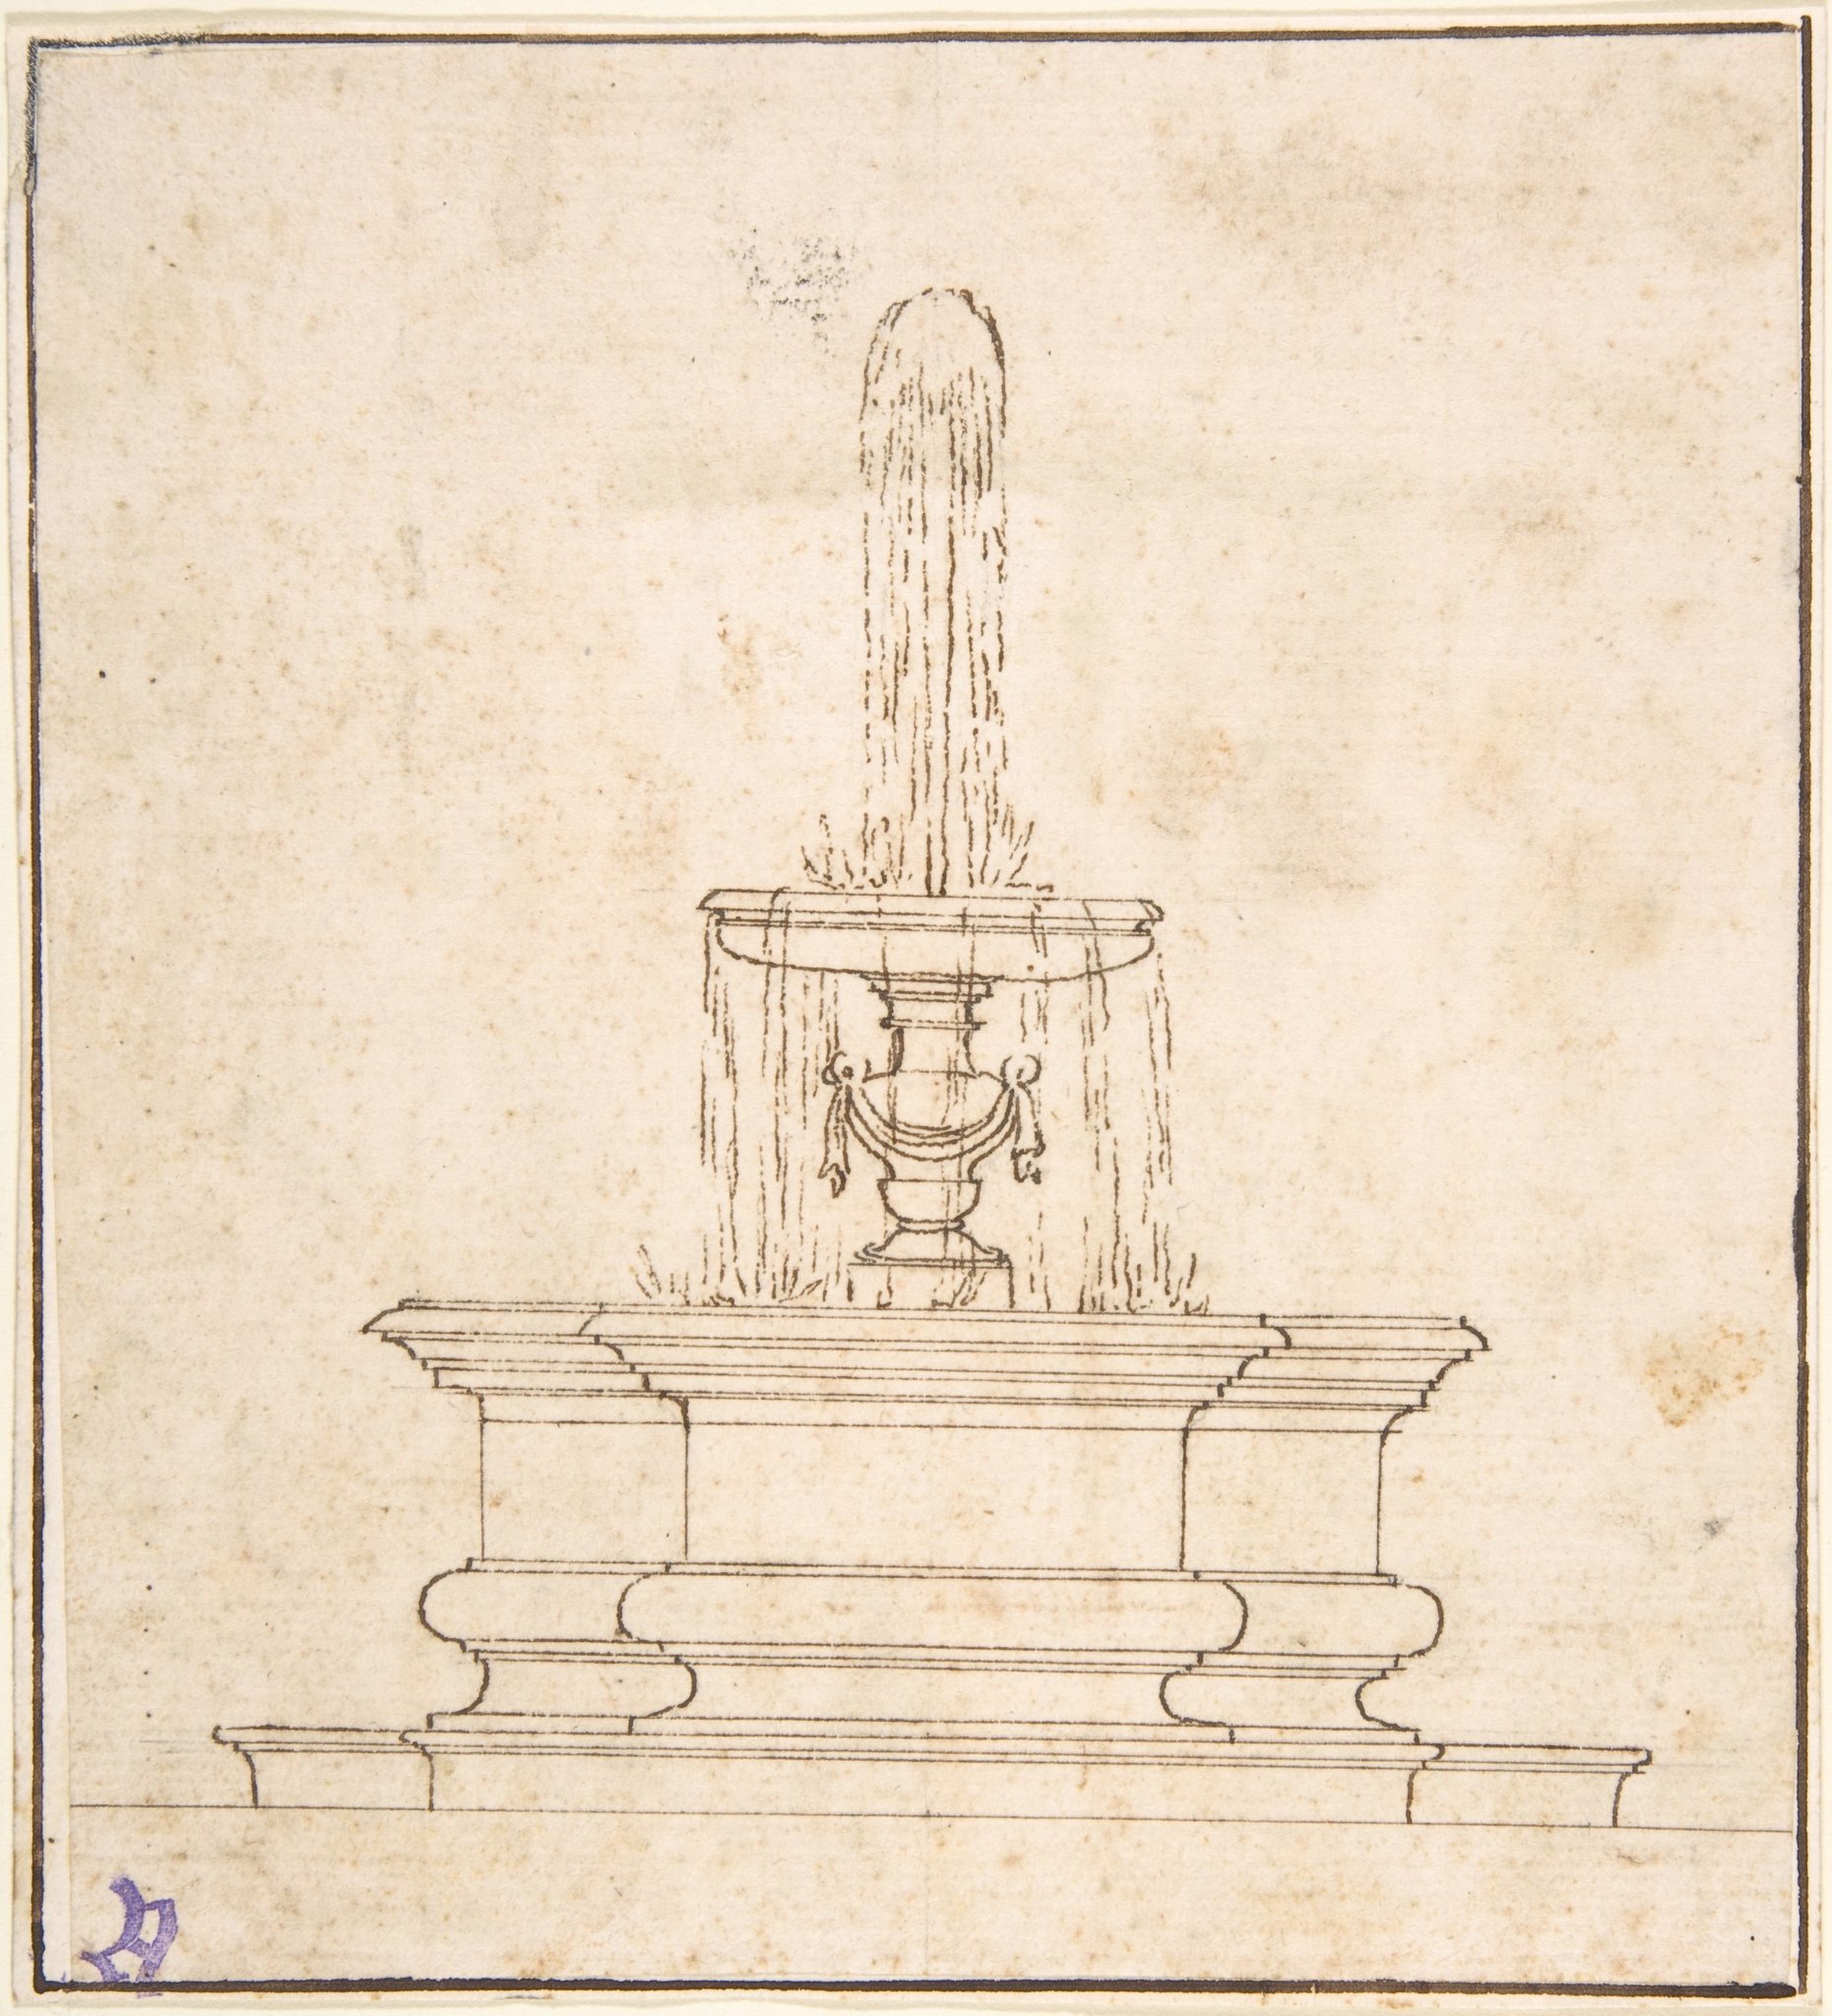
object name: drawing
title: Project for a Fountain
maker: anonymous, italian, 16th to 17th century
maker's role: artist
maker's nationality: italian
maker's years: 1500-1700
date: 1501-1700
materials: graphite, ink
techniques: pen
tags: fountains